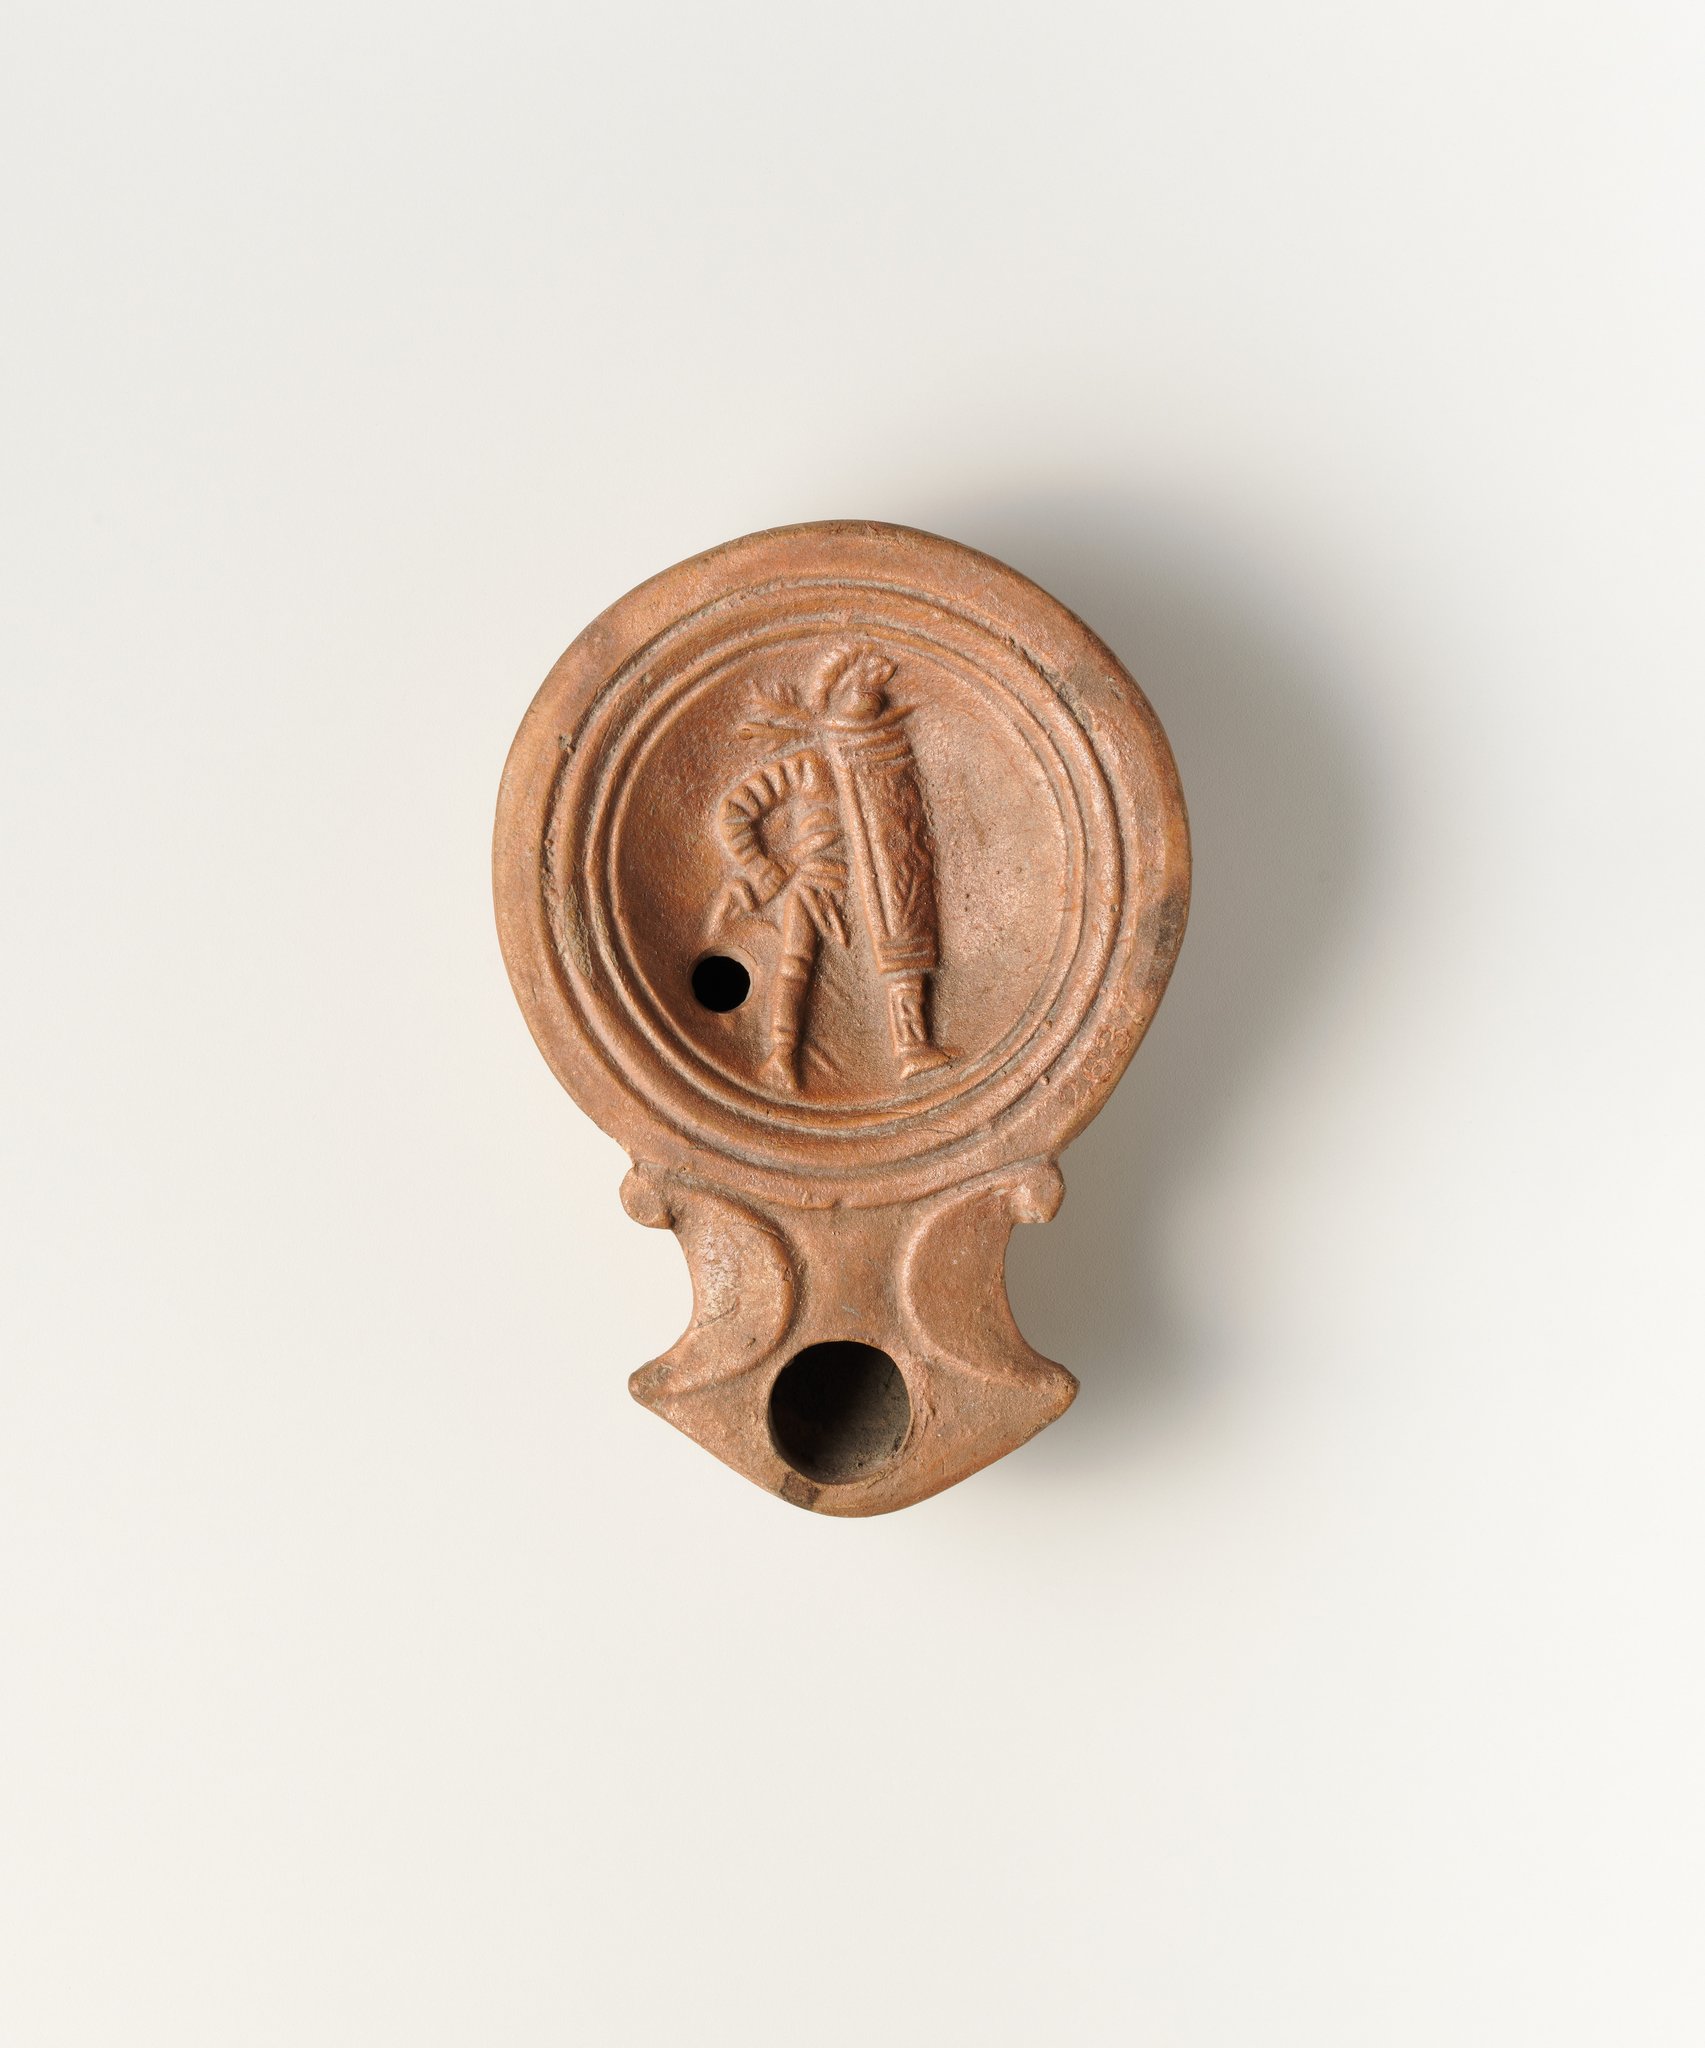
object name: lamp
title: Terracotta oil lamp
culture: roman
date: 40-80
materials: terracotta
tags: armor,men,gladiators